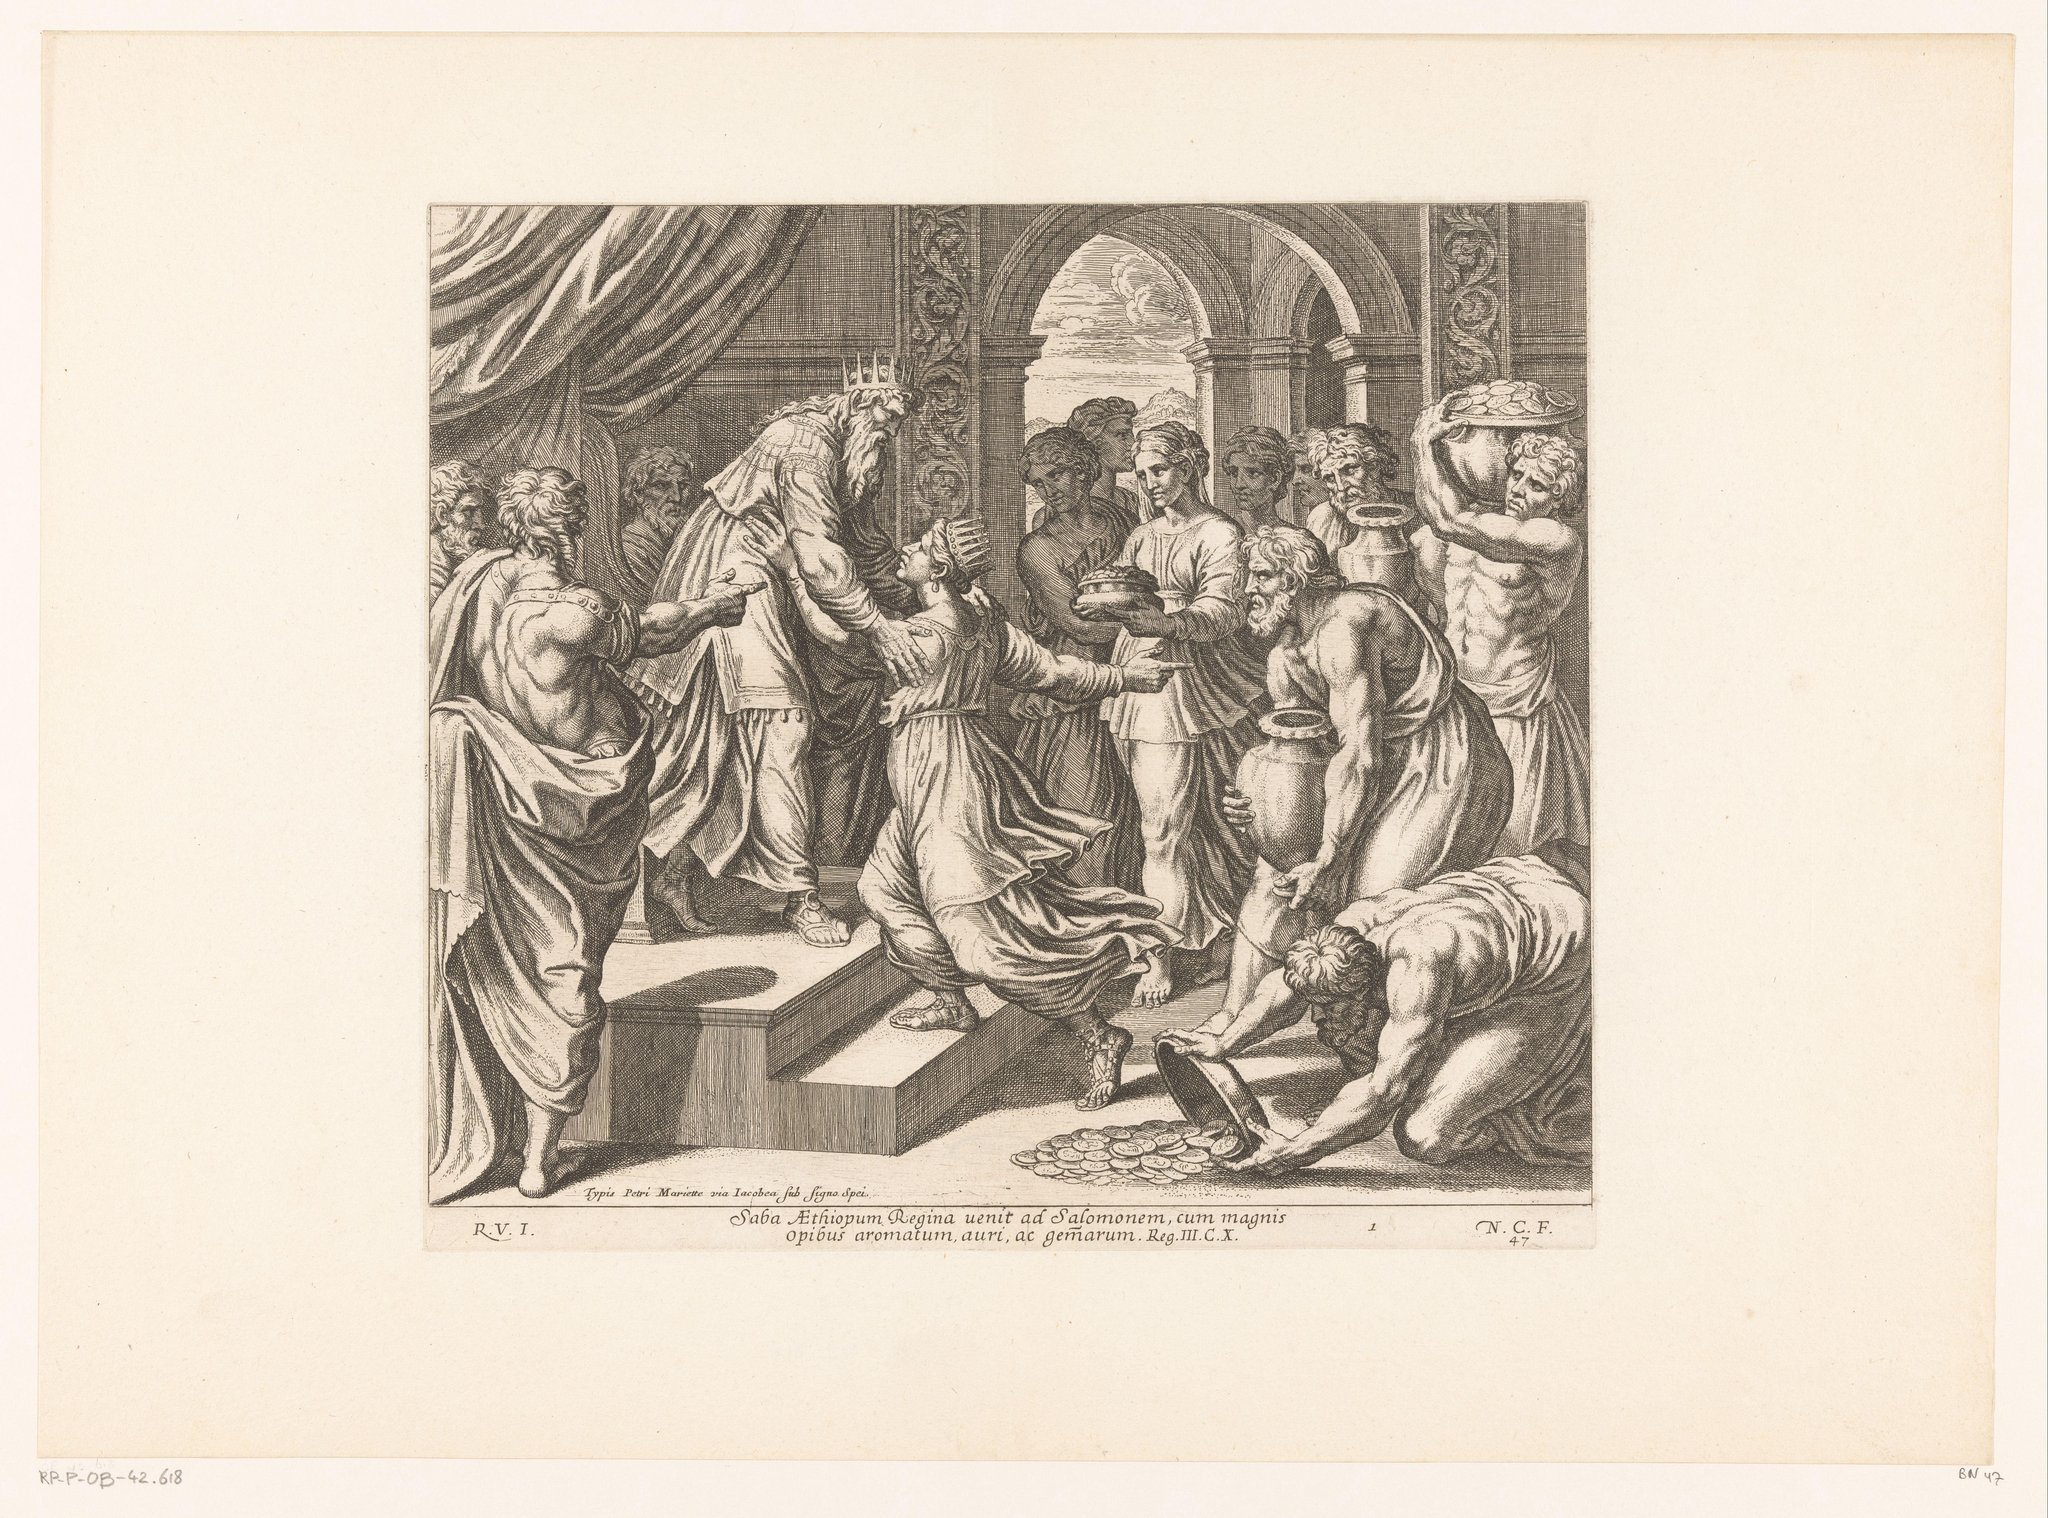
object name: print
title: Sacrae Historiae Acta a Raphael Urbin in Vaticanis xystis ad picturae miraculum expressa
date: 1649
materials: paper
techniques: etching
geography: vatican city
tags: solomon and the queen of sheba (1 kings 10:1-3; 2 chronicles 9:1-9), homage to solomon: the queen of sheba gives solomon gold, precious stones and spices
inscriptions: collector's mark: Lugt 2228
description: Prent uit de Sacrae Historiae Acta a Raphael Urbin in Vaticanis xystis ad picturae miraculum expressa, ook bekend als de Rafaël Bijbel. De serie bestaat uit 54 platen, waarvan twee titelprenten, de eerste met een opdracht aan Rafaël, de tweede met een opdracht aan Renard. De overige 52 platen betreffen composities naar schilderingen in de Loggia van Rafaël in het Vaticaan. De serie werd in 1649 uitgegeven door Pierre Mariette te Parijs.